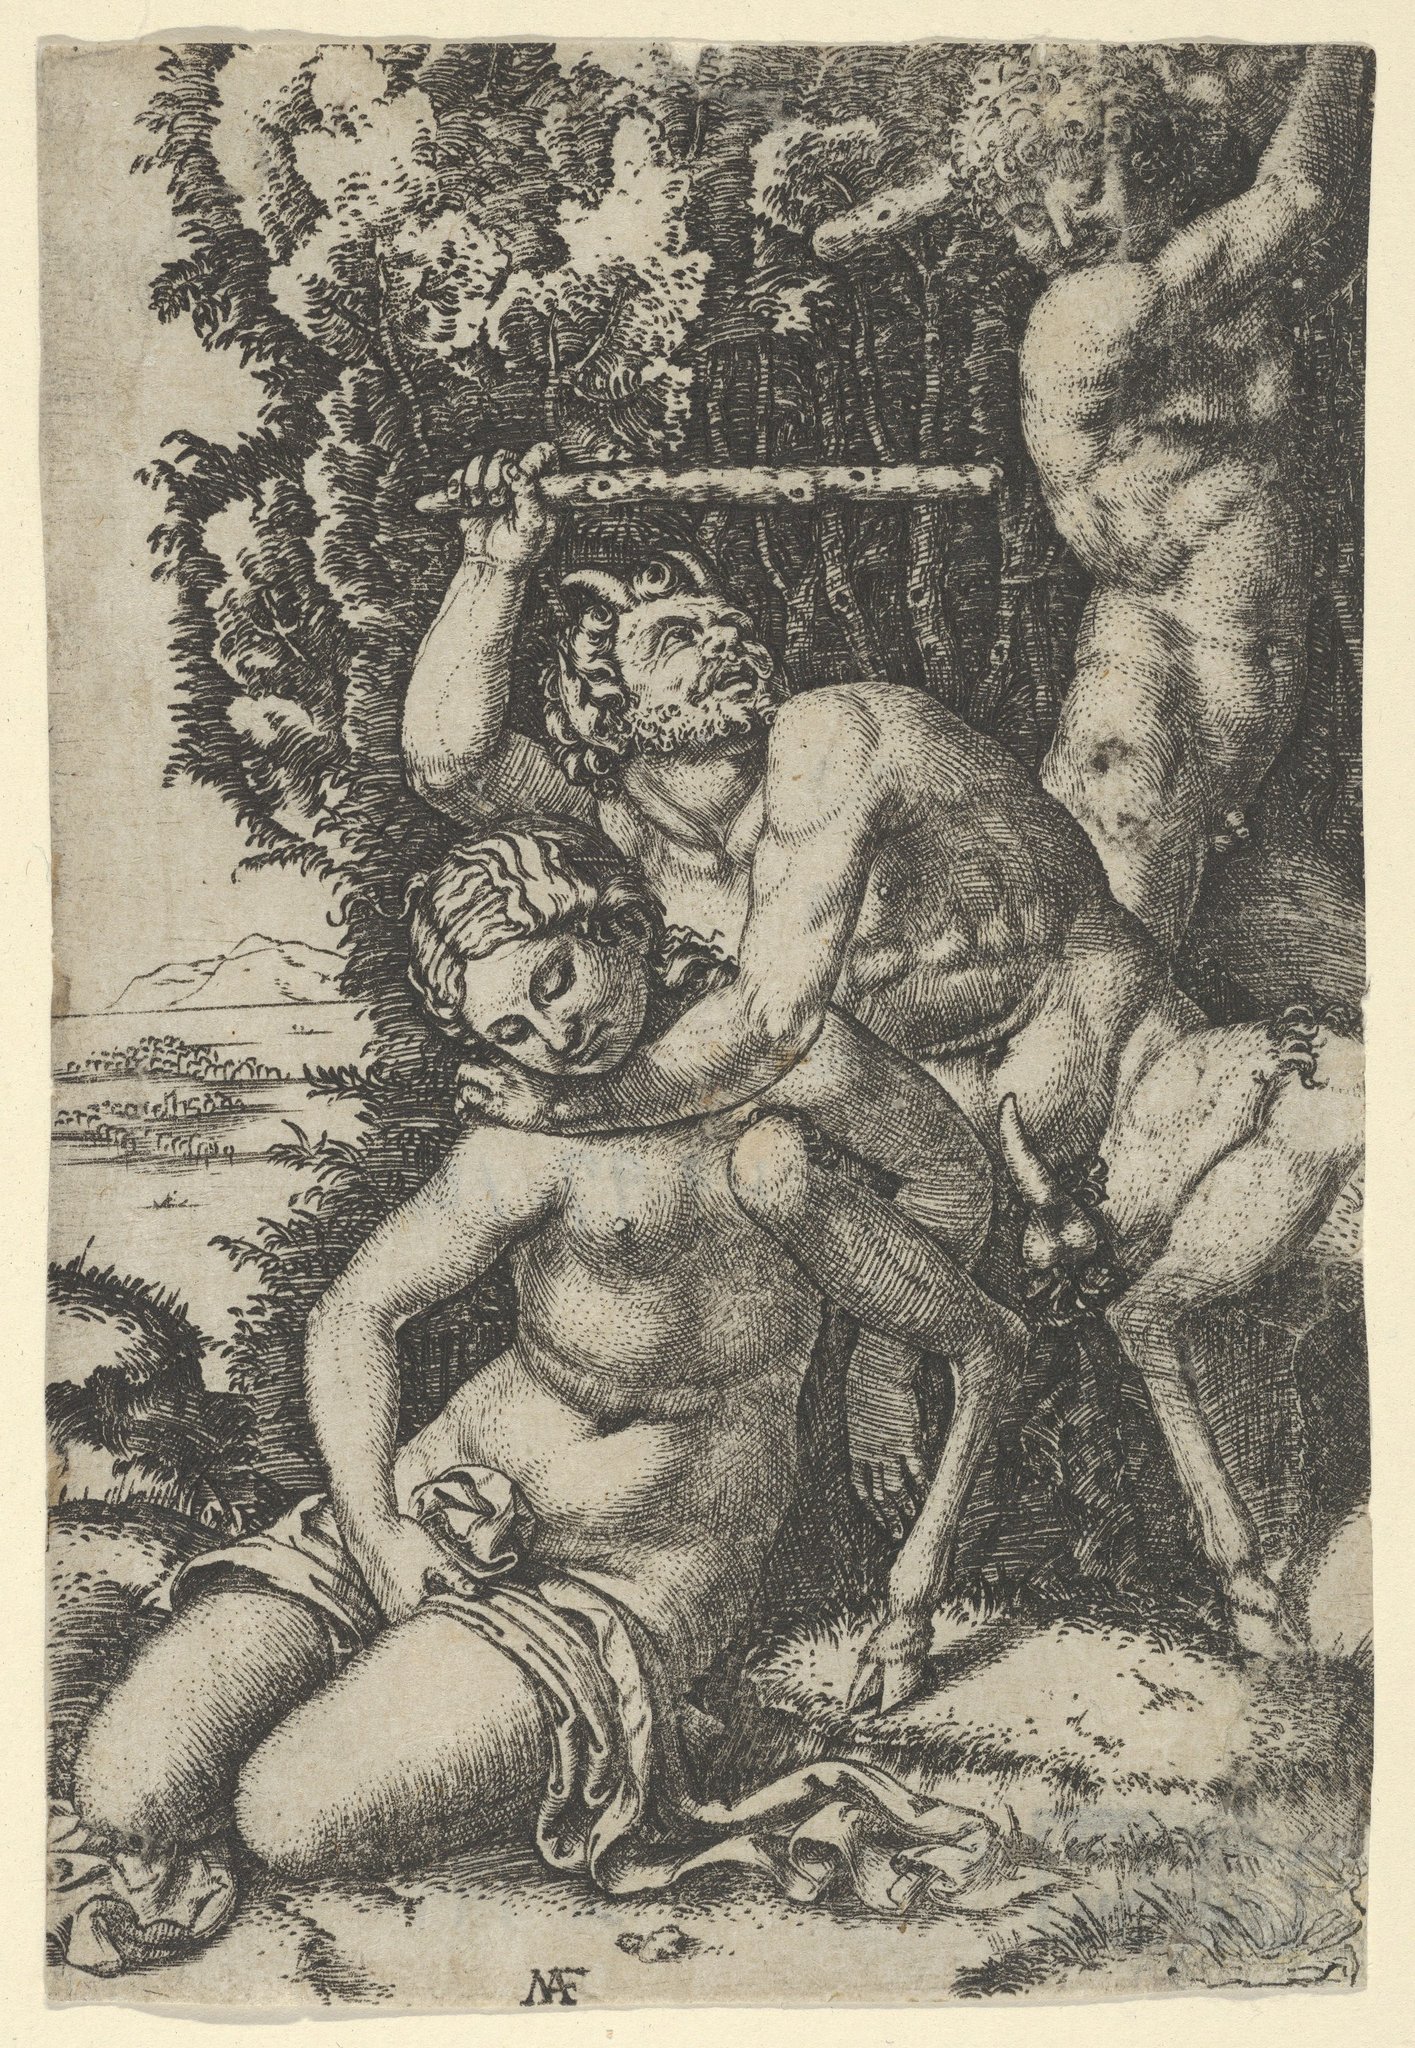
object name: print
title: A satyr fighting for a nymph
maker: Anonymous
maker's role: artist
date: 1510-1540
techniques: engraving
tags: male nudes,nymphs,satyrs,trees